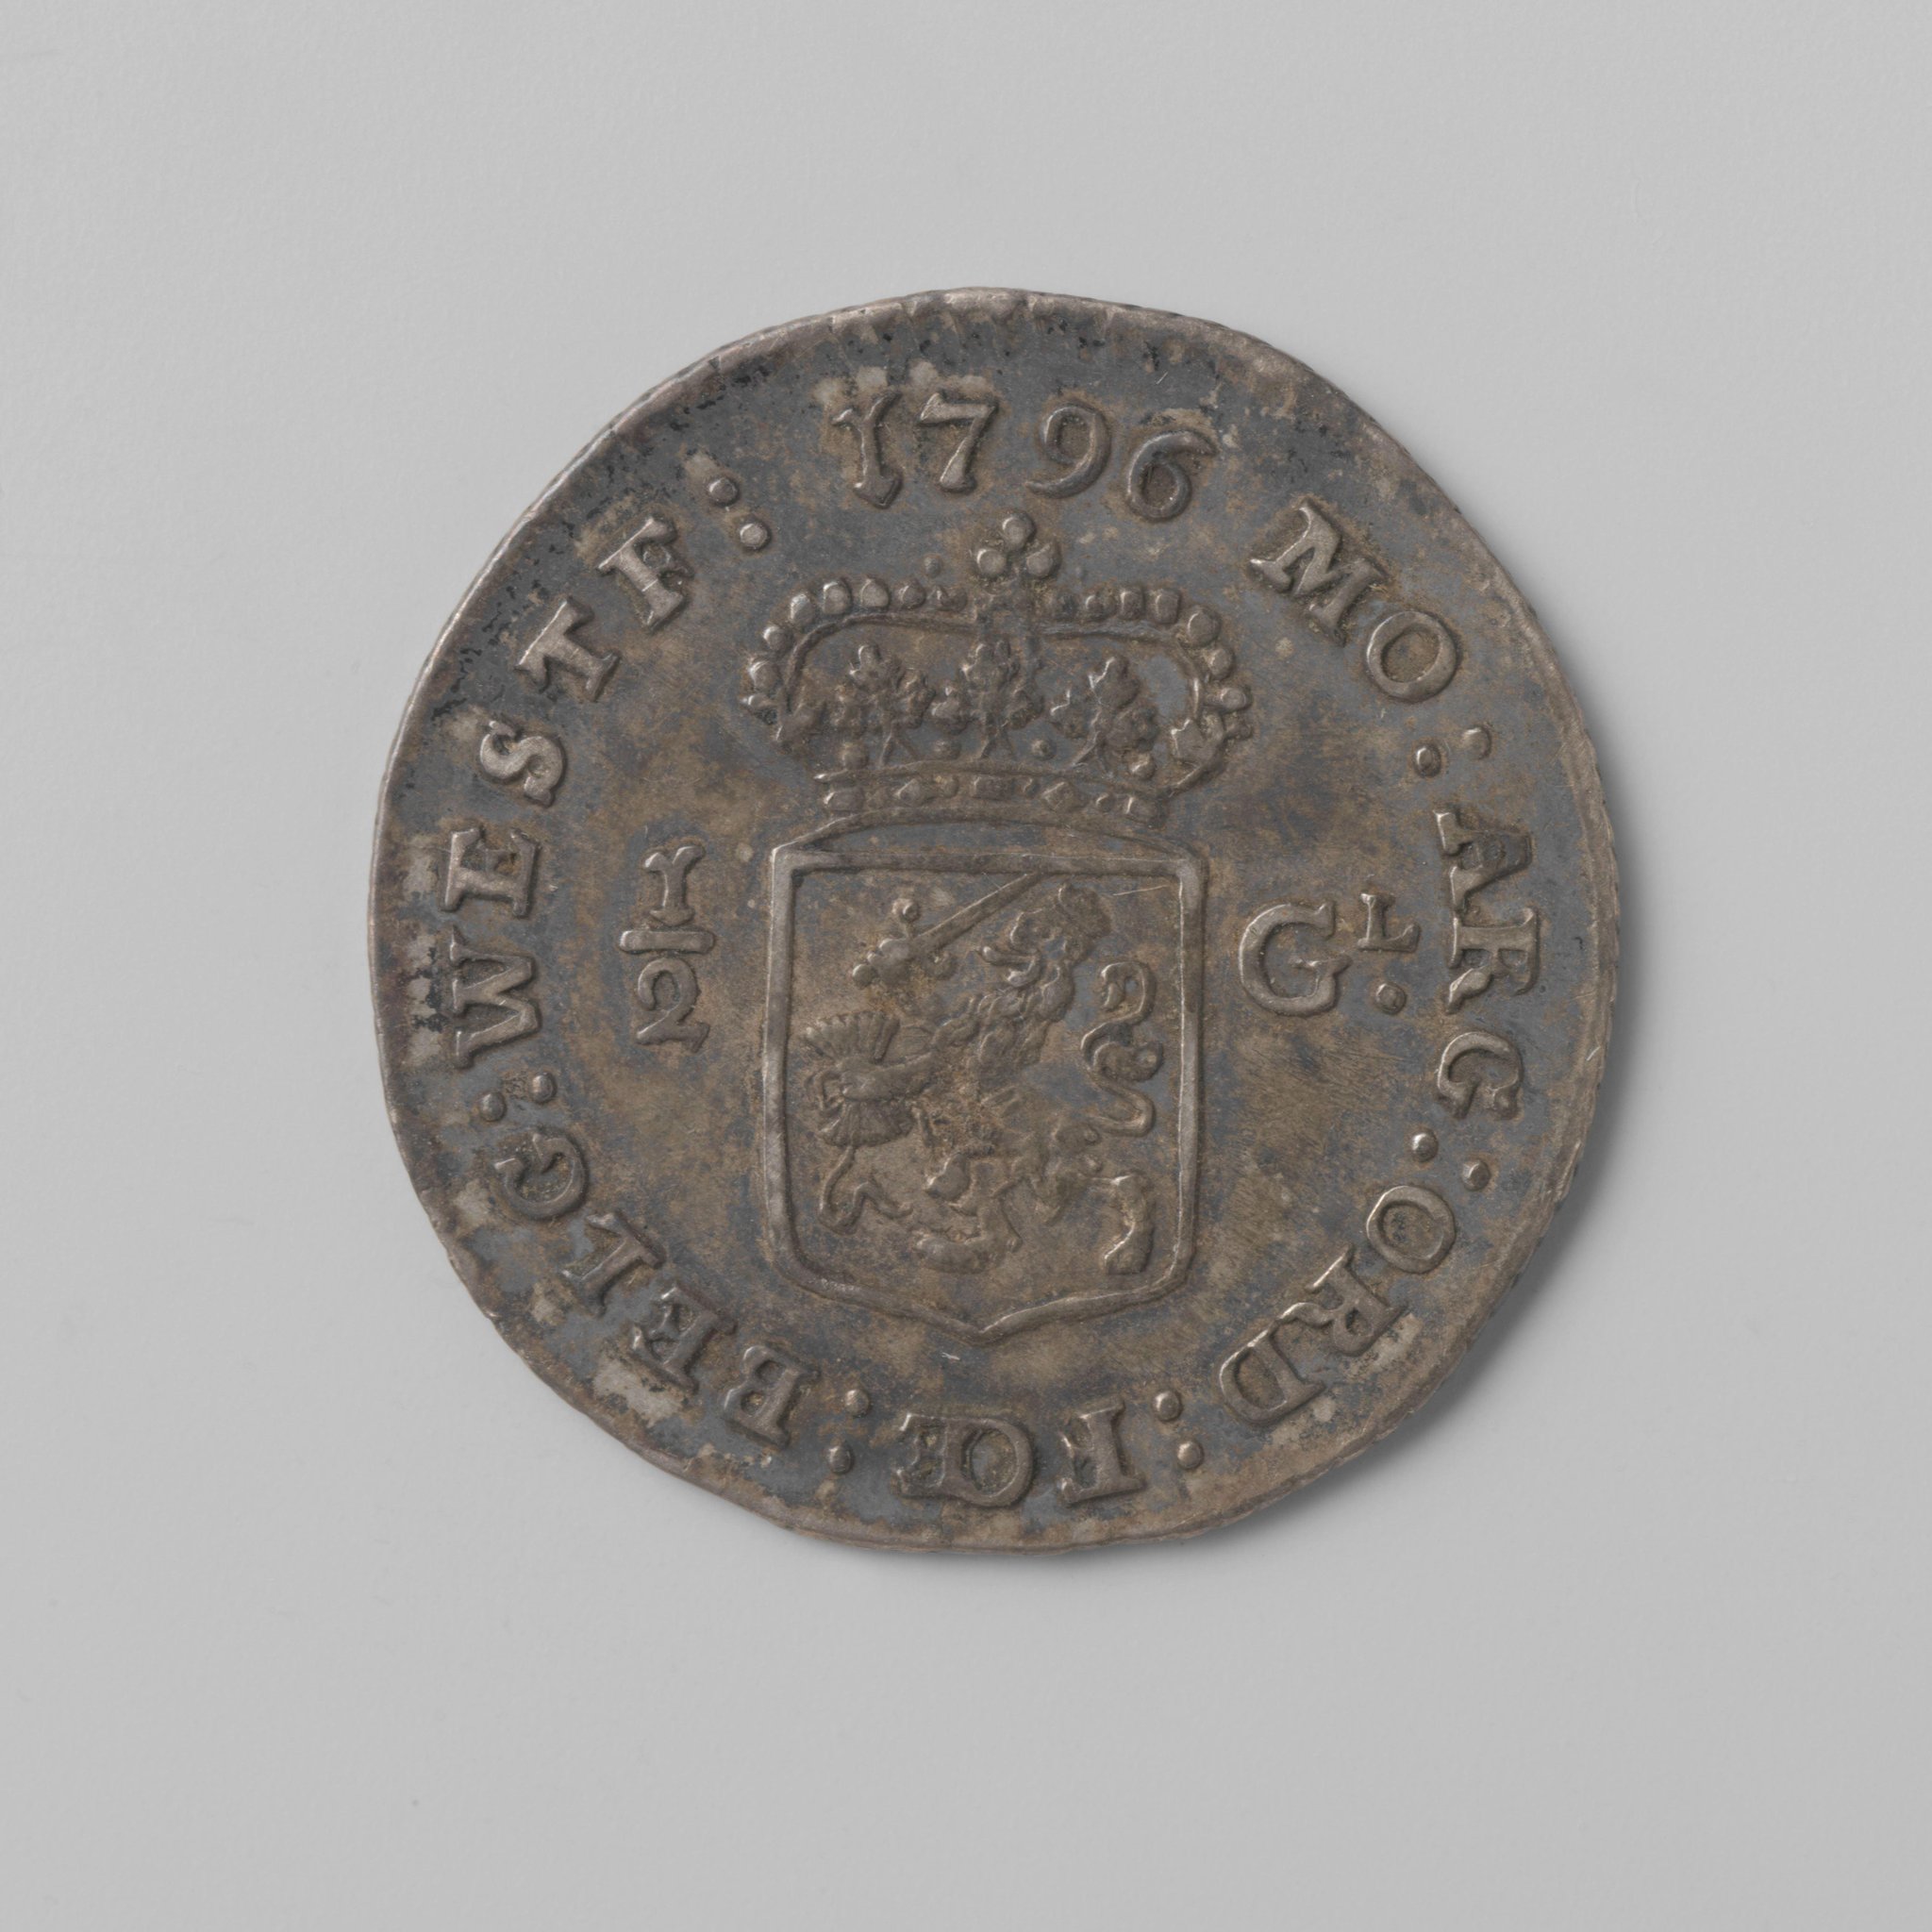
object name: halve gulden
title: West-Friesland, halve gulden, 1796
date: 1796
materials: silver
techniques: striking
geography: west frisia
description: Zilveren munt.Voorzijde: tussen waarde-aanduiding gekroond generaliteirtswapenschild. Keerzijde: Nederlandse maagd met vrijheidshoed en speer, leunend op een bijbel op een altaar. In afsnede jaartal. Kabelrand.